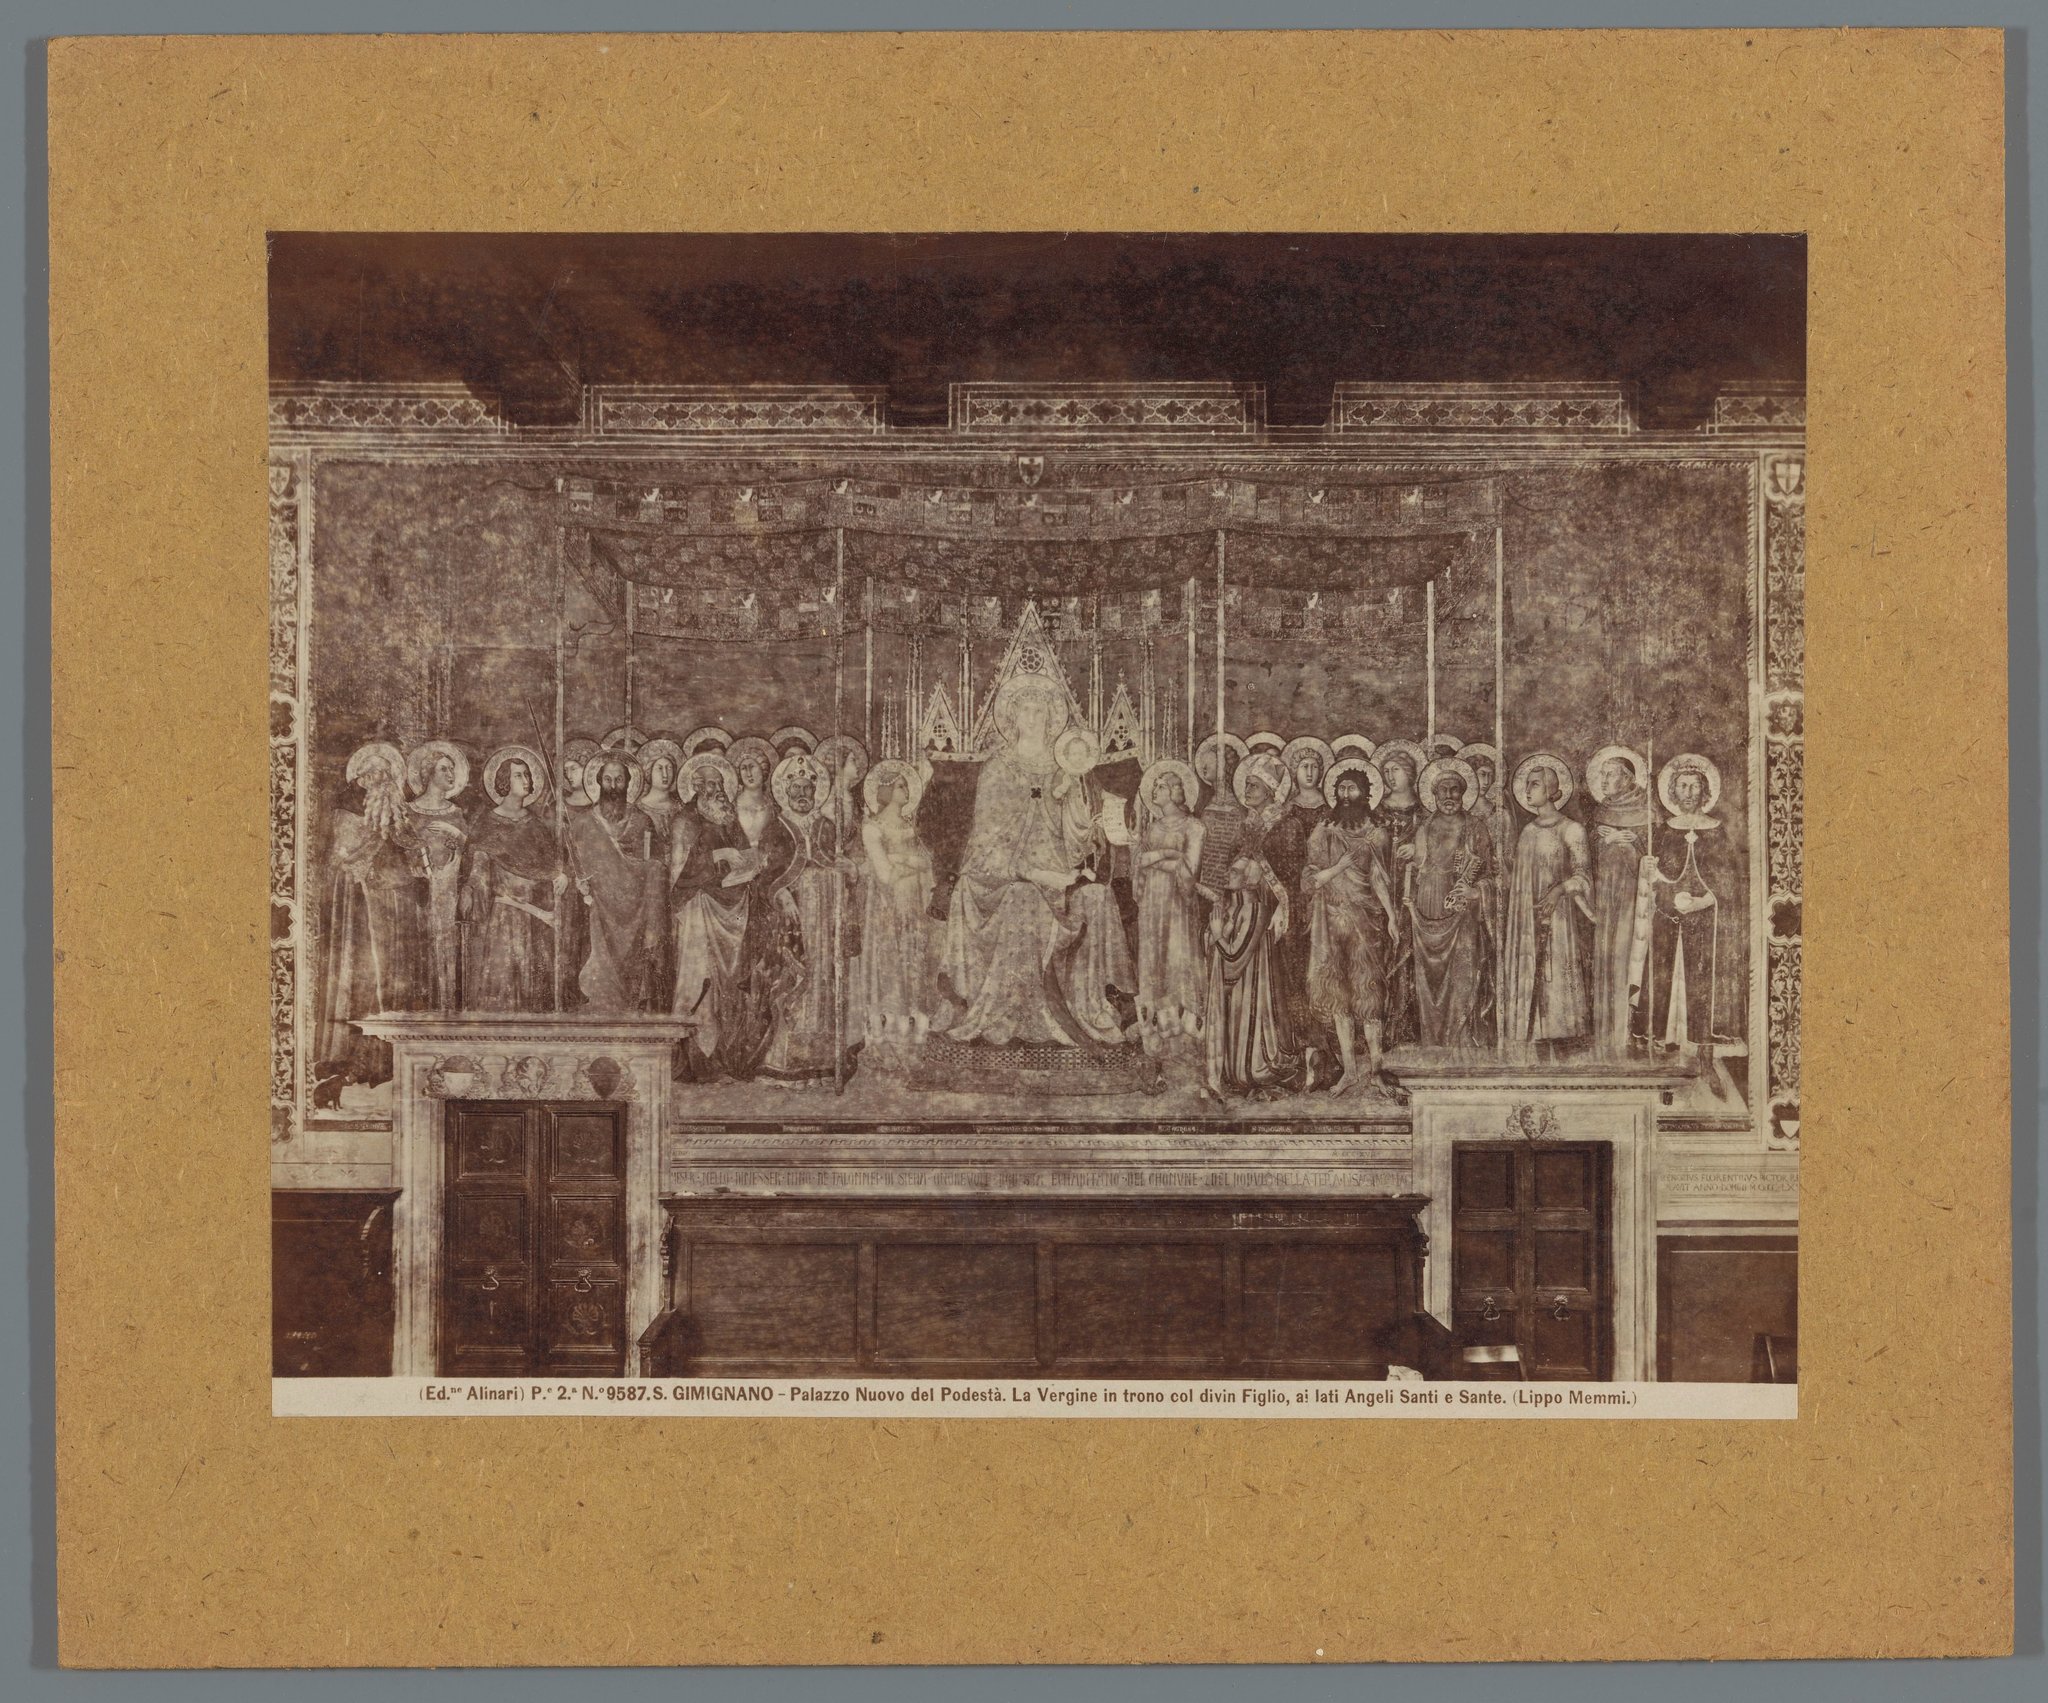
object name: photograph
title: Schildering door L. Memmi in het stadhuis van San Gimignano, voorstellende Maria met Kind op een troon omringd door heiligen en engelen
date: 1875-1900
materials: cardboard, photographic support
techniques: albumen print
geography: san gimignano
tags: madonna: mary sitting or enthroned, the christ-child in her lap (or in front of her bosom) (mary sometimes represented half-length), saints, interior ~ representation of a building, female saints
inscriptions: collector's mark: Lugt 3937, number: ‘P.e 2.a N.o 9587.’